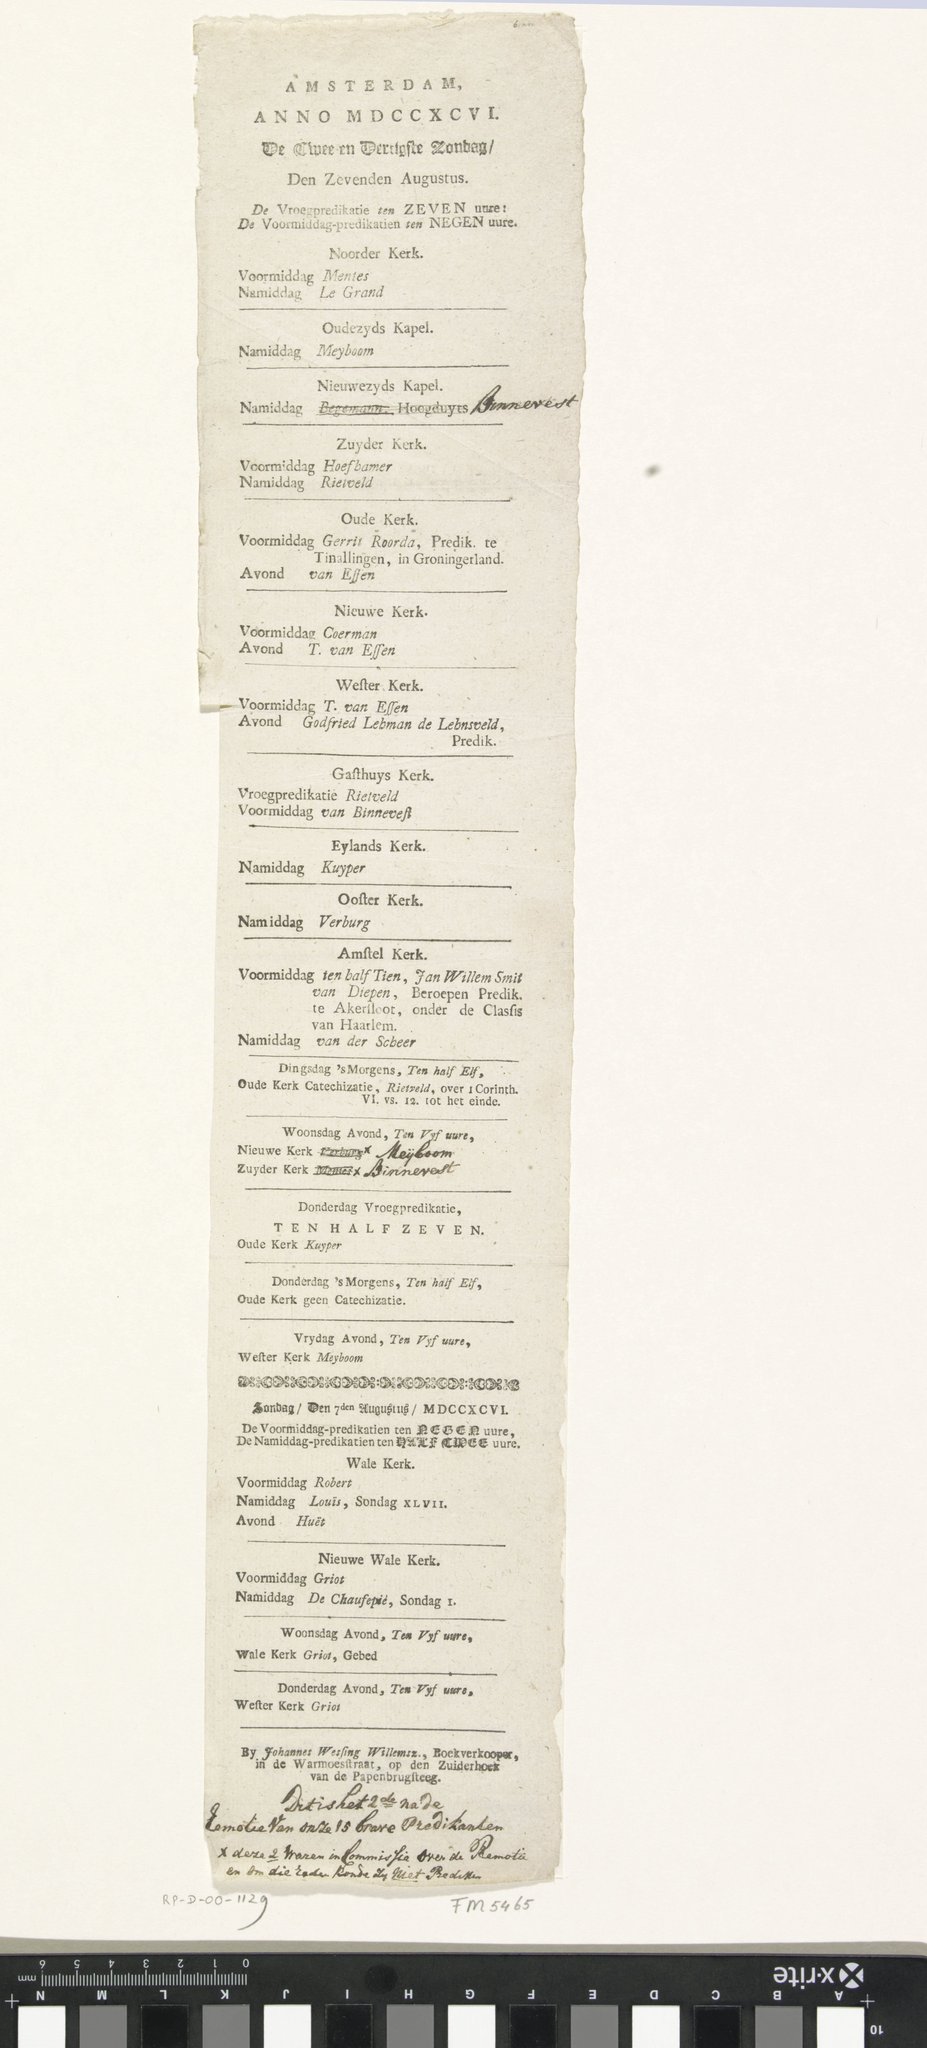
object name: text sheet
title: Predikantenbriefje Amsterdam 7 augustus 1796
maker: johannes wessing willemsz.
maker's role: publisher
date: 1708-1796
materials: paper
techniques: letterpress printing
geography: amsterdam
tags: amsterdam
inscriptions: collector's mark: Lugt 2228, inscription: ‘Dit is het 2de na de Remotie van onze 15 brave Predikanten / x deze 2 waren in Commissie over de Remotie en om die reden konde zij niet Prediken’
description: Predikantenbriefje, met een overzicht van de kerken van Amsterdam en welke predikanten op zondag 7 augustus 1796 aldaar de dienst zullen leiden. Tweede predikantenbriefje verschenen na de remotie van 15 Oranjegezinde predikanten te Amsterdam. Enkele namen zijn met de pen doorgestreept en vervangen door andere namen.